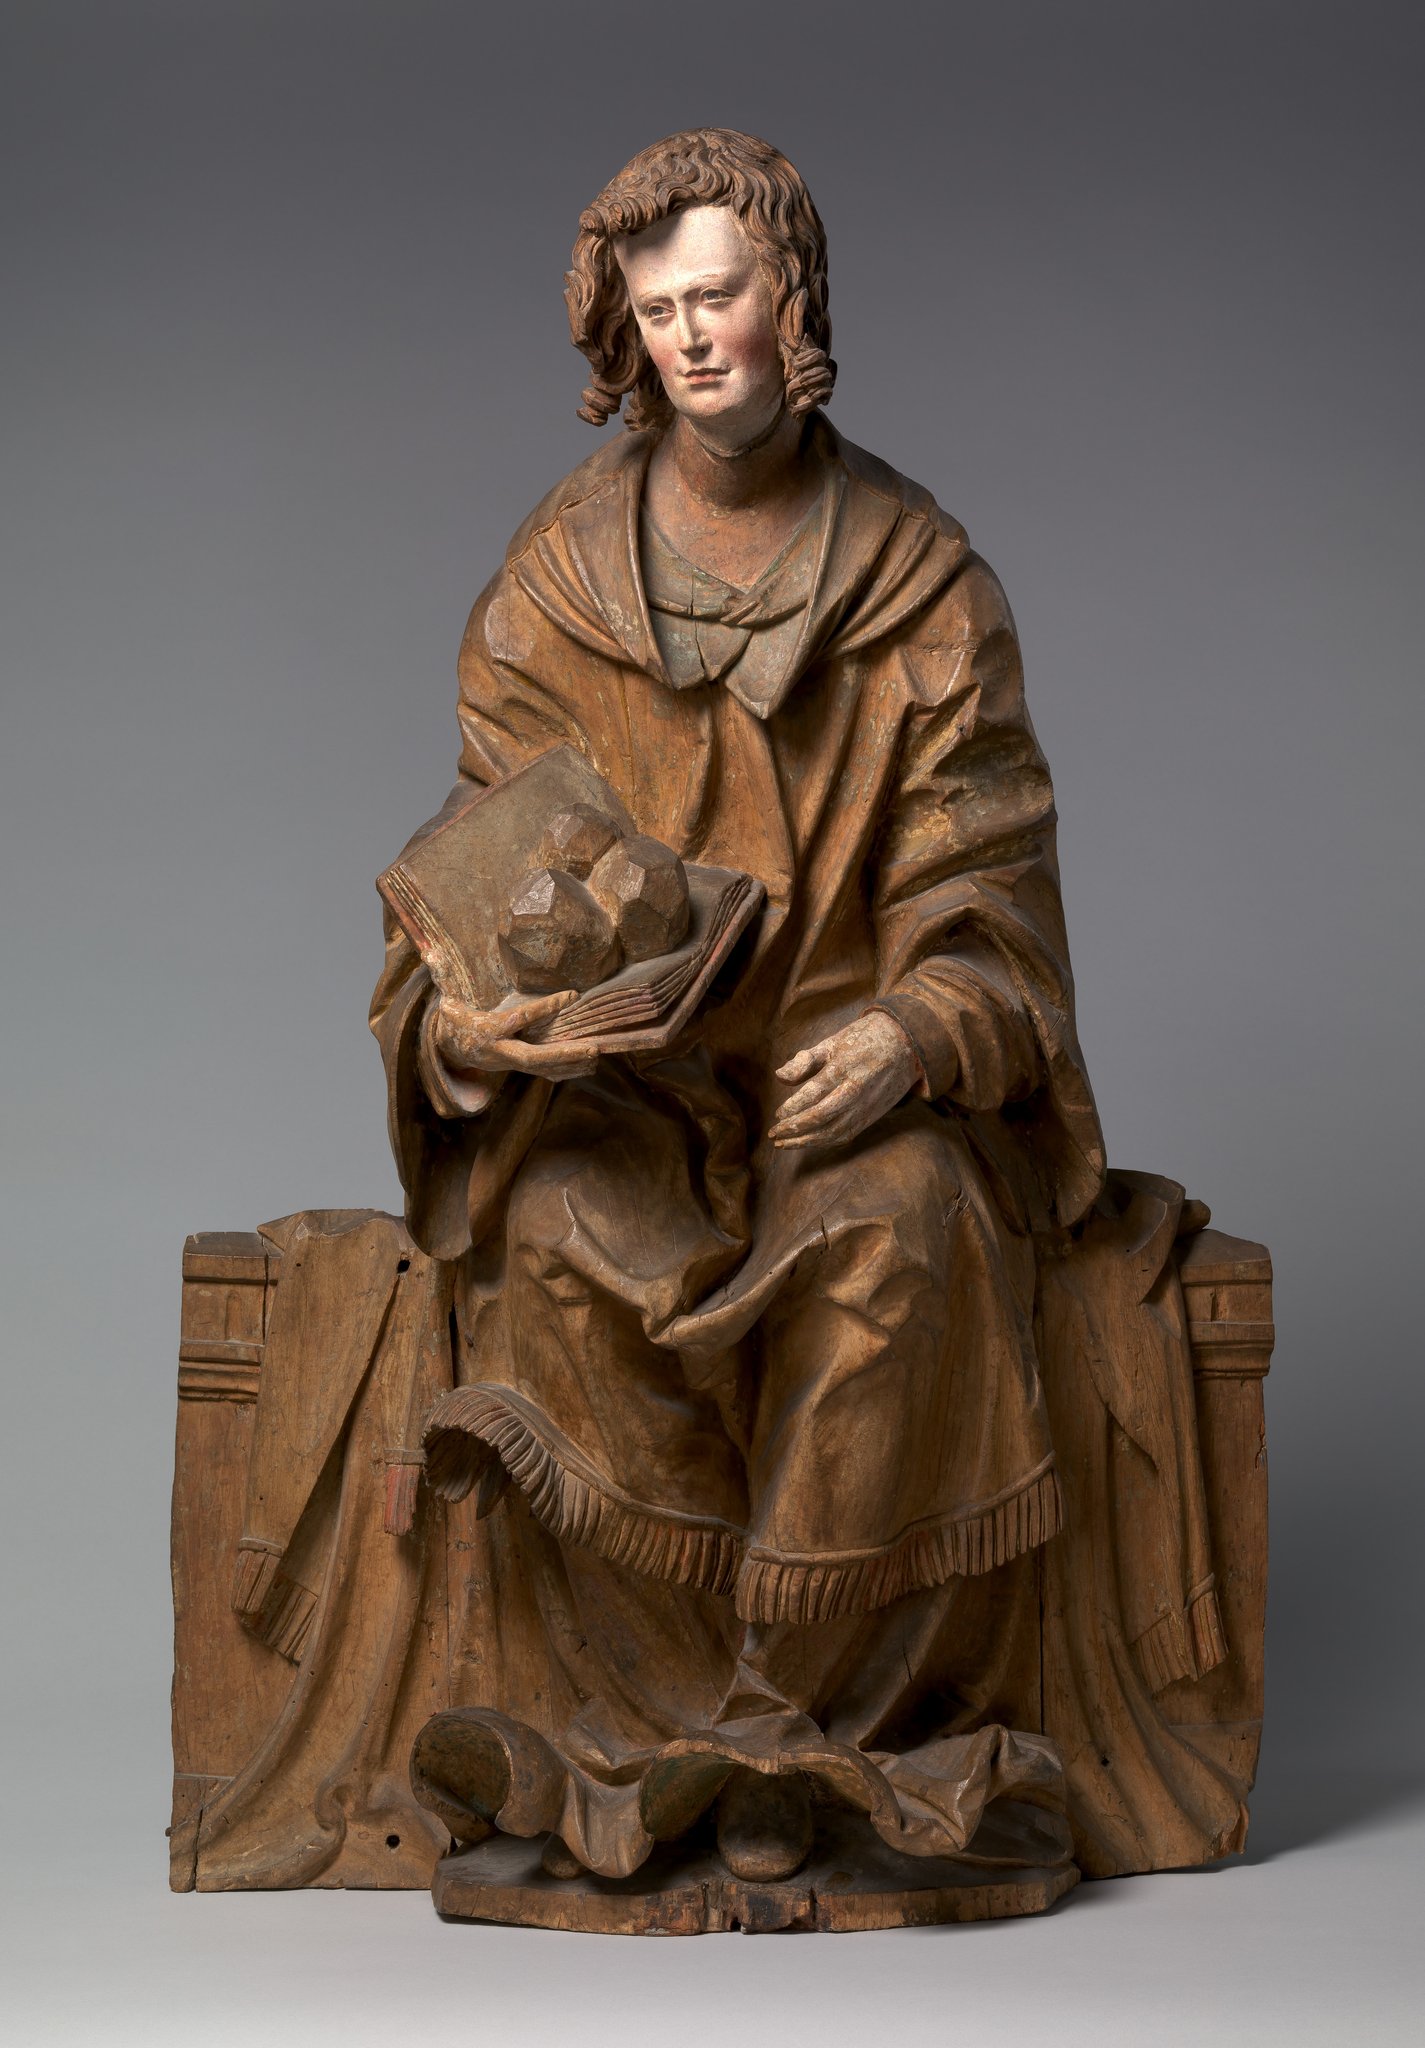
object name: sculpture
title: Saint Stephen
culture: german, south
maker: hans leinberger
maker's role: artist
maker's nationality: german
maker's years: 1510-1530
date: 1525-1530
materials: paint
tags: men,saints